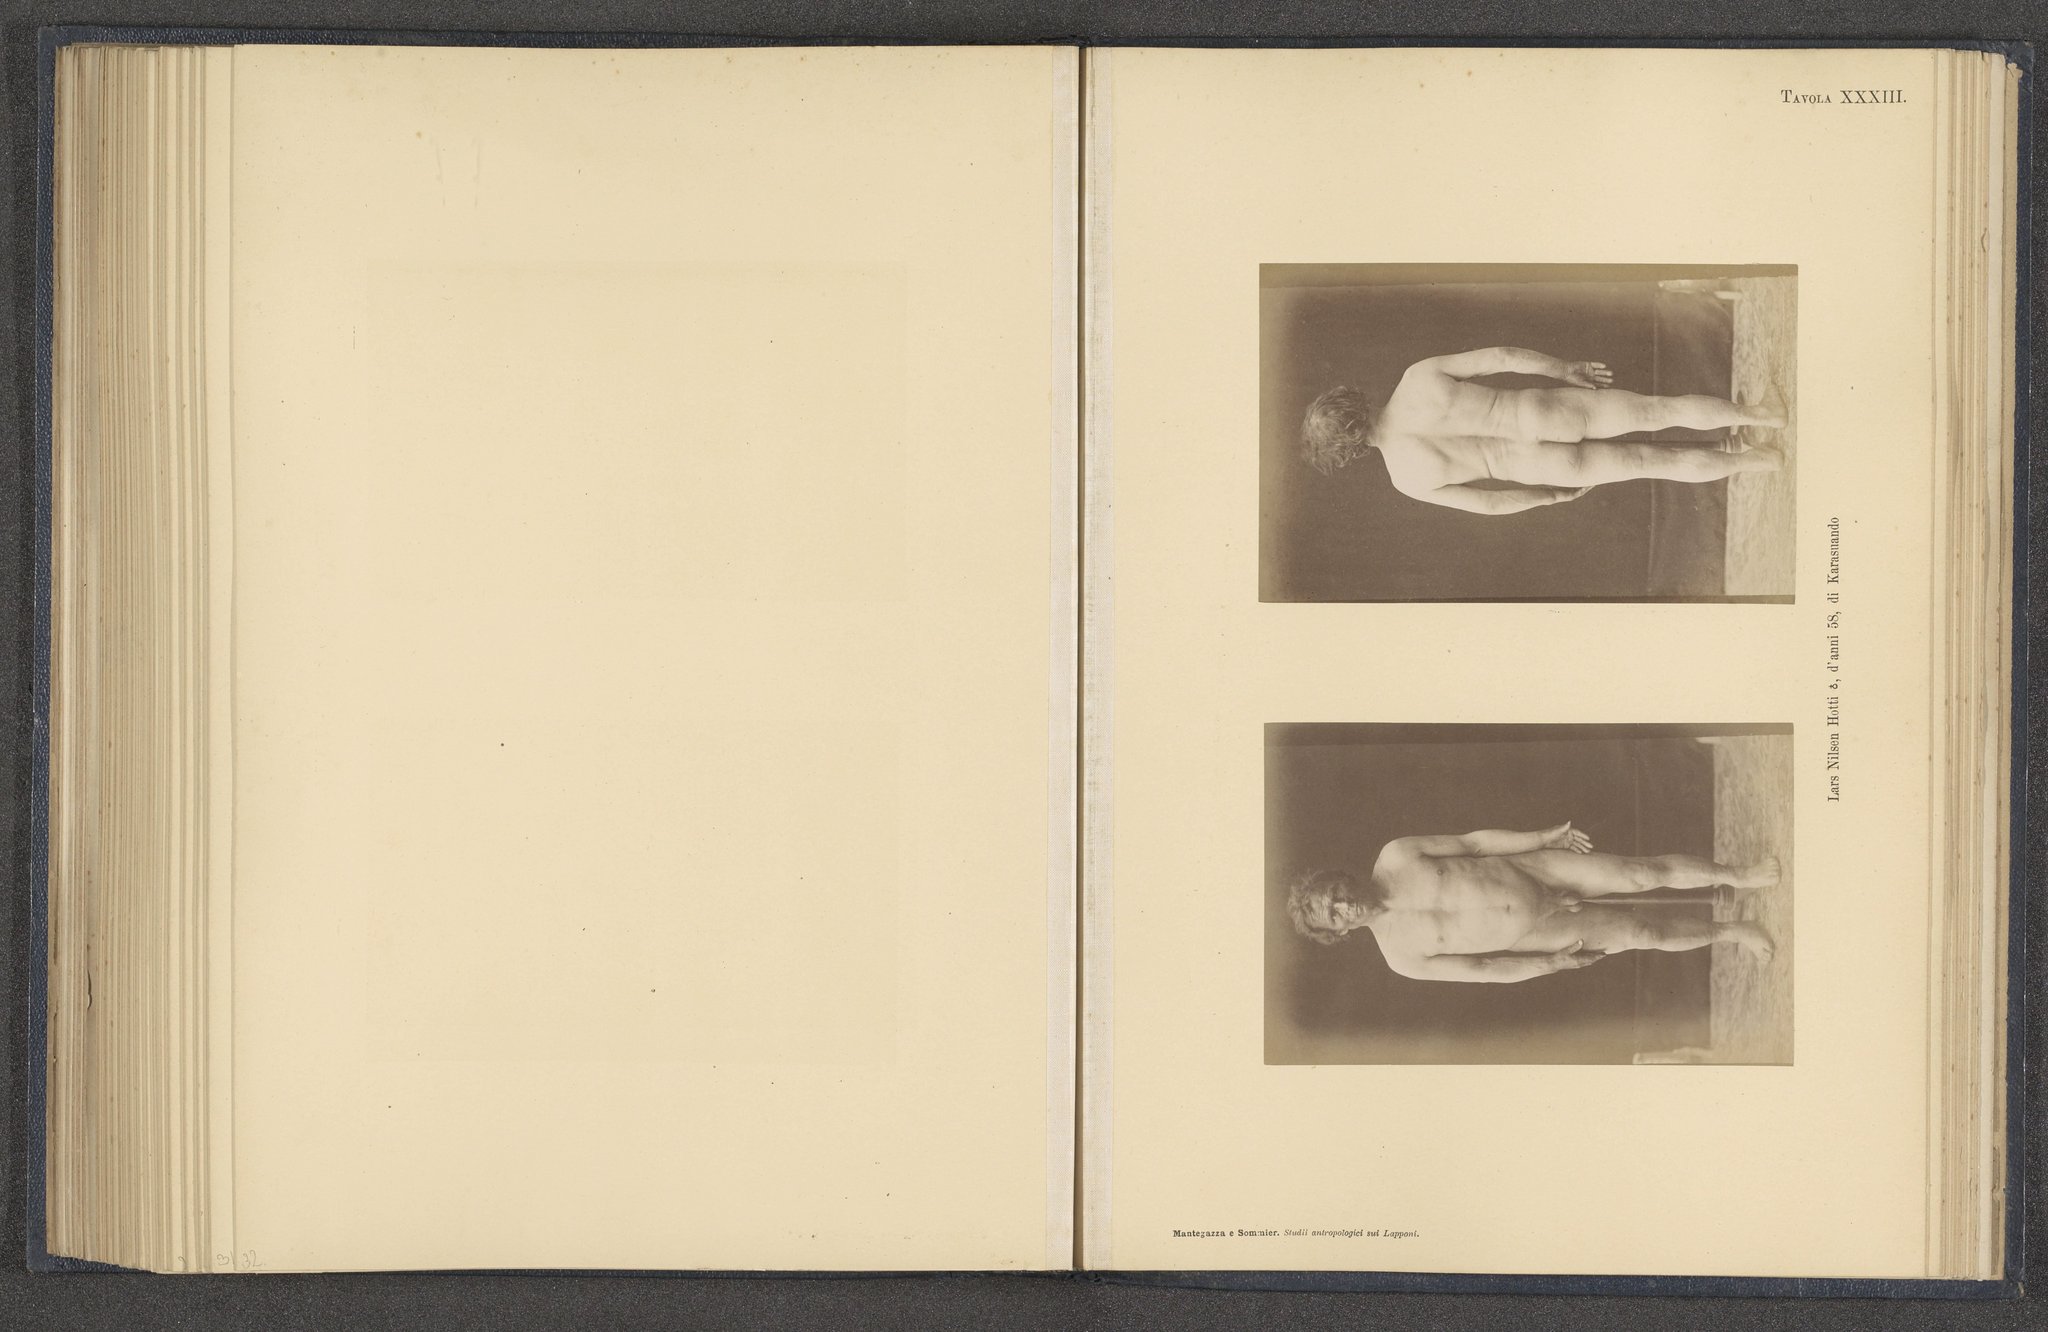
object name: page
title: Twee naaktfoto's van Lars Nilsen Hotti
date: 1870-1880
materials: paper, photographic support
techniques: albumen print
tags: man (showing himself) undressed, quasi-nude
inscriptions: number: ‘Tavola XXXIII.’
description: Links een vooraanzicht, rechts een achteraanzicht.